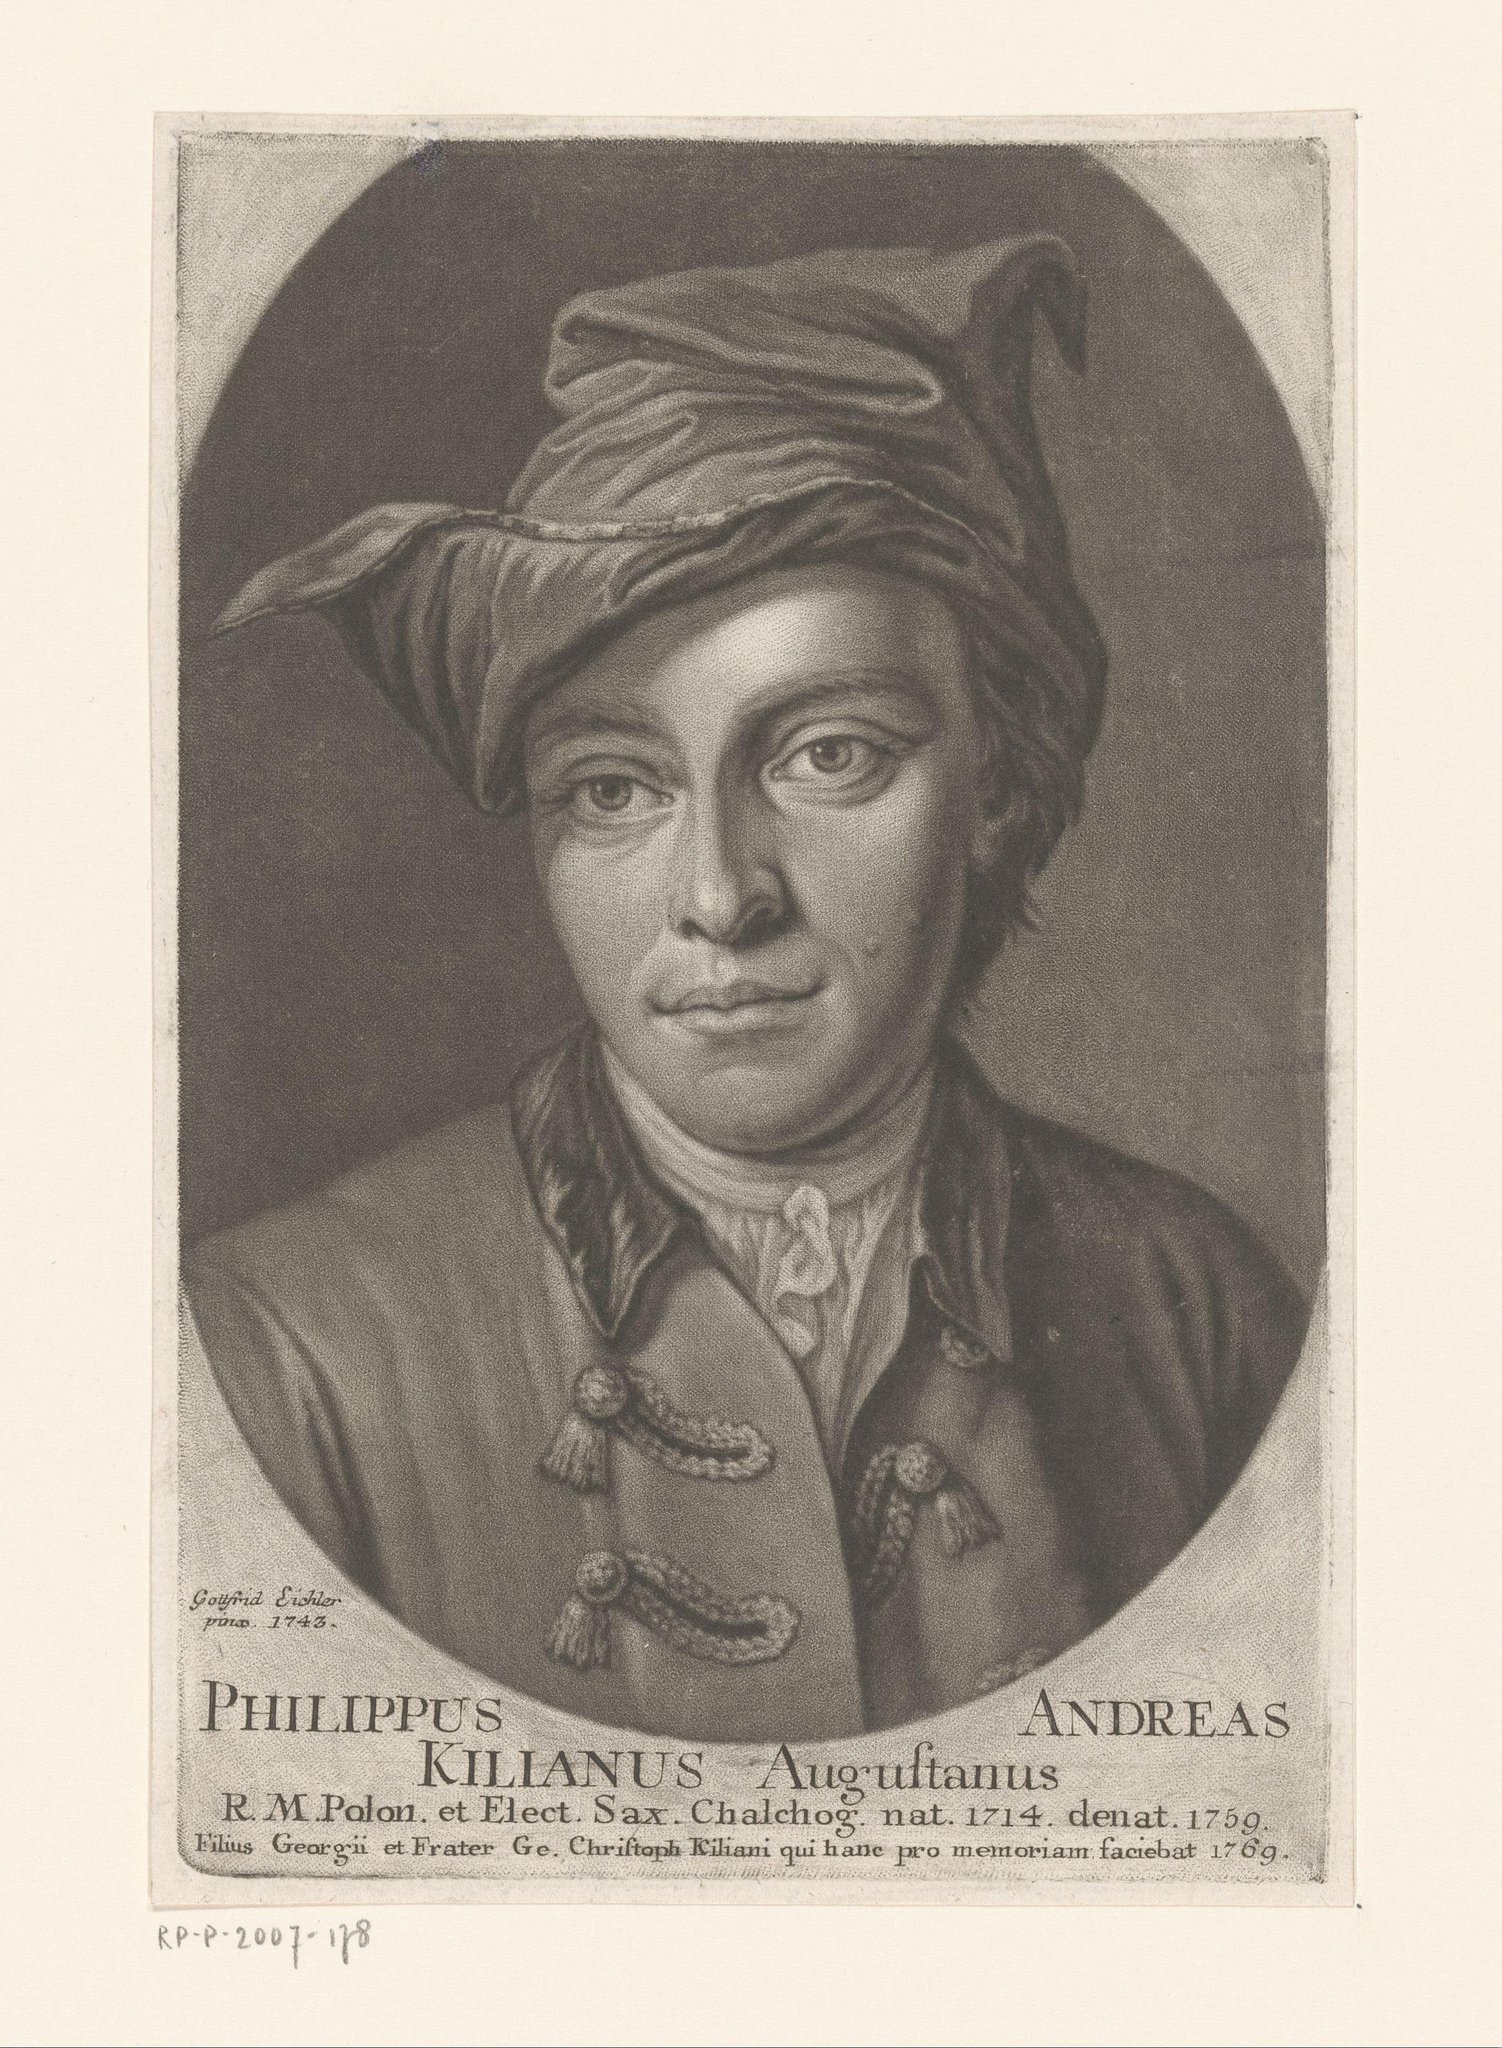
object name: print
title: Portret van Philipp Andreas Kilian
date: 1769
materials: paper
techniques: mezzotint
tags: painter, philipp andreas kilian, historical persons, portrait, self-portrait of graphic artist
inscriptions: collector's mark: Lugt 2760, collector's mark: Lugt 2228